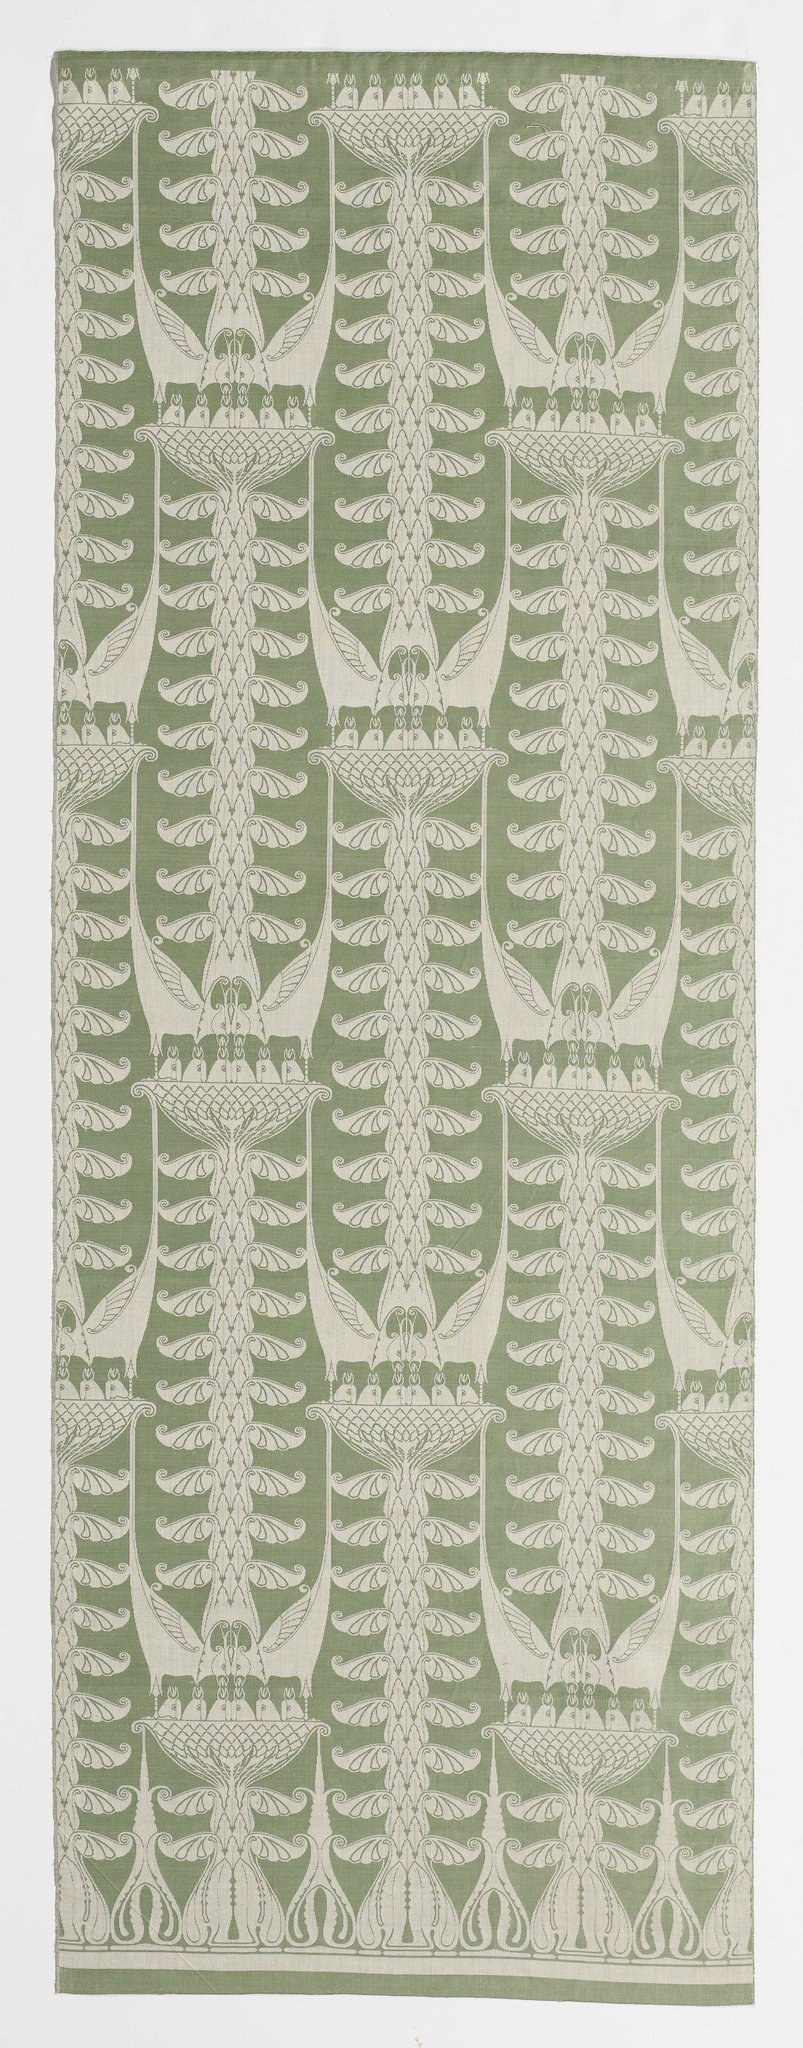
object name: upholstered wall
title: Wandbespanning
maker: chris lebeau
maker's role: draughtsman, print maker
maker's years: 1878-1945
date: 1911-1915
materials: linen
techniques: damask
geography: eindhoven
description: Donkerolijfgroene groene damasten wandbespanning met een dessin van vogelnesten.